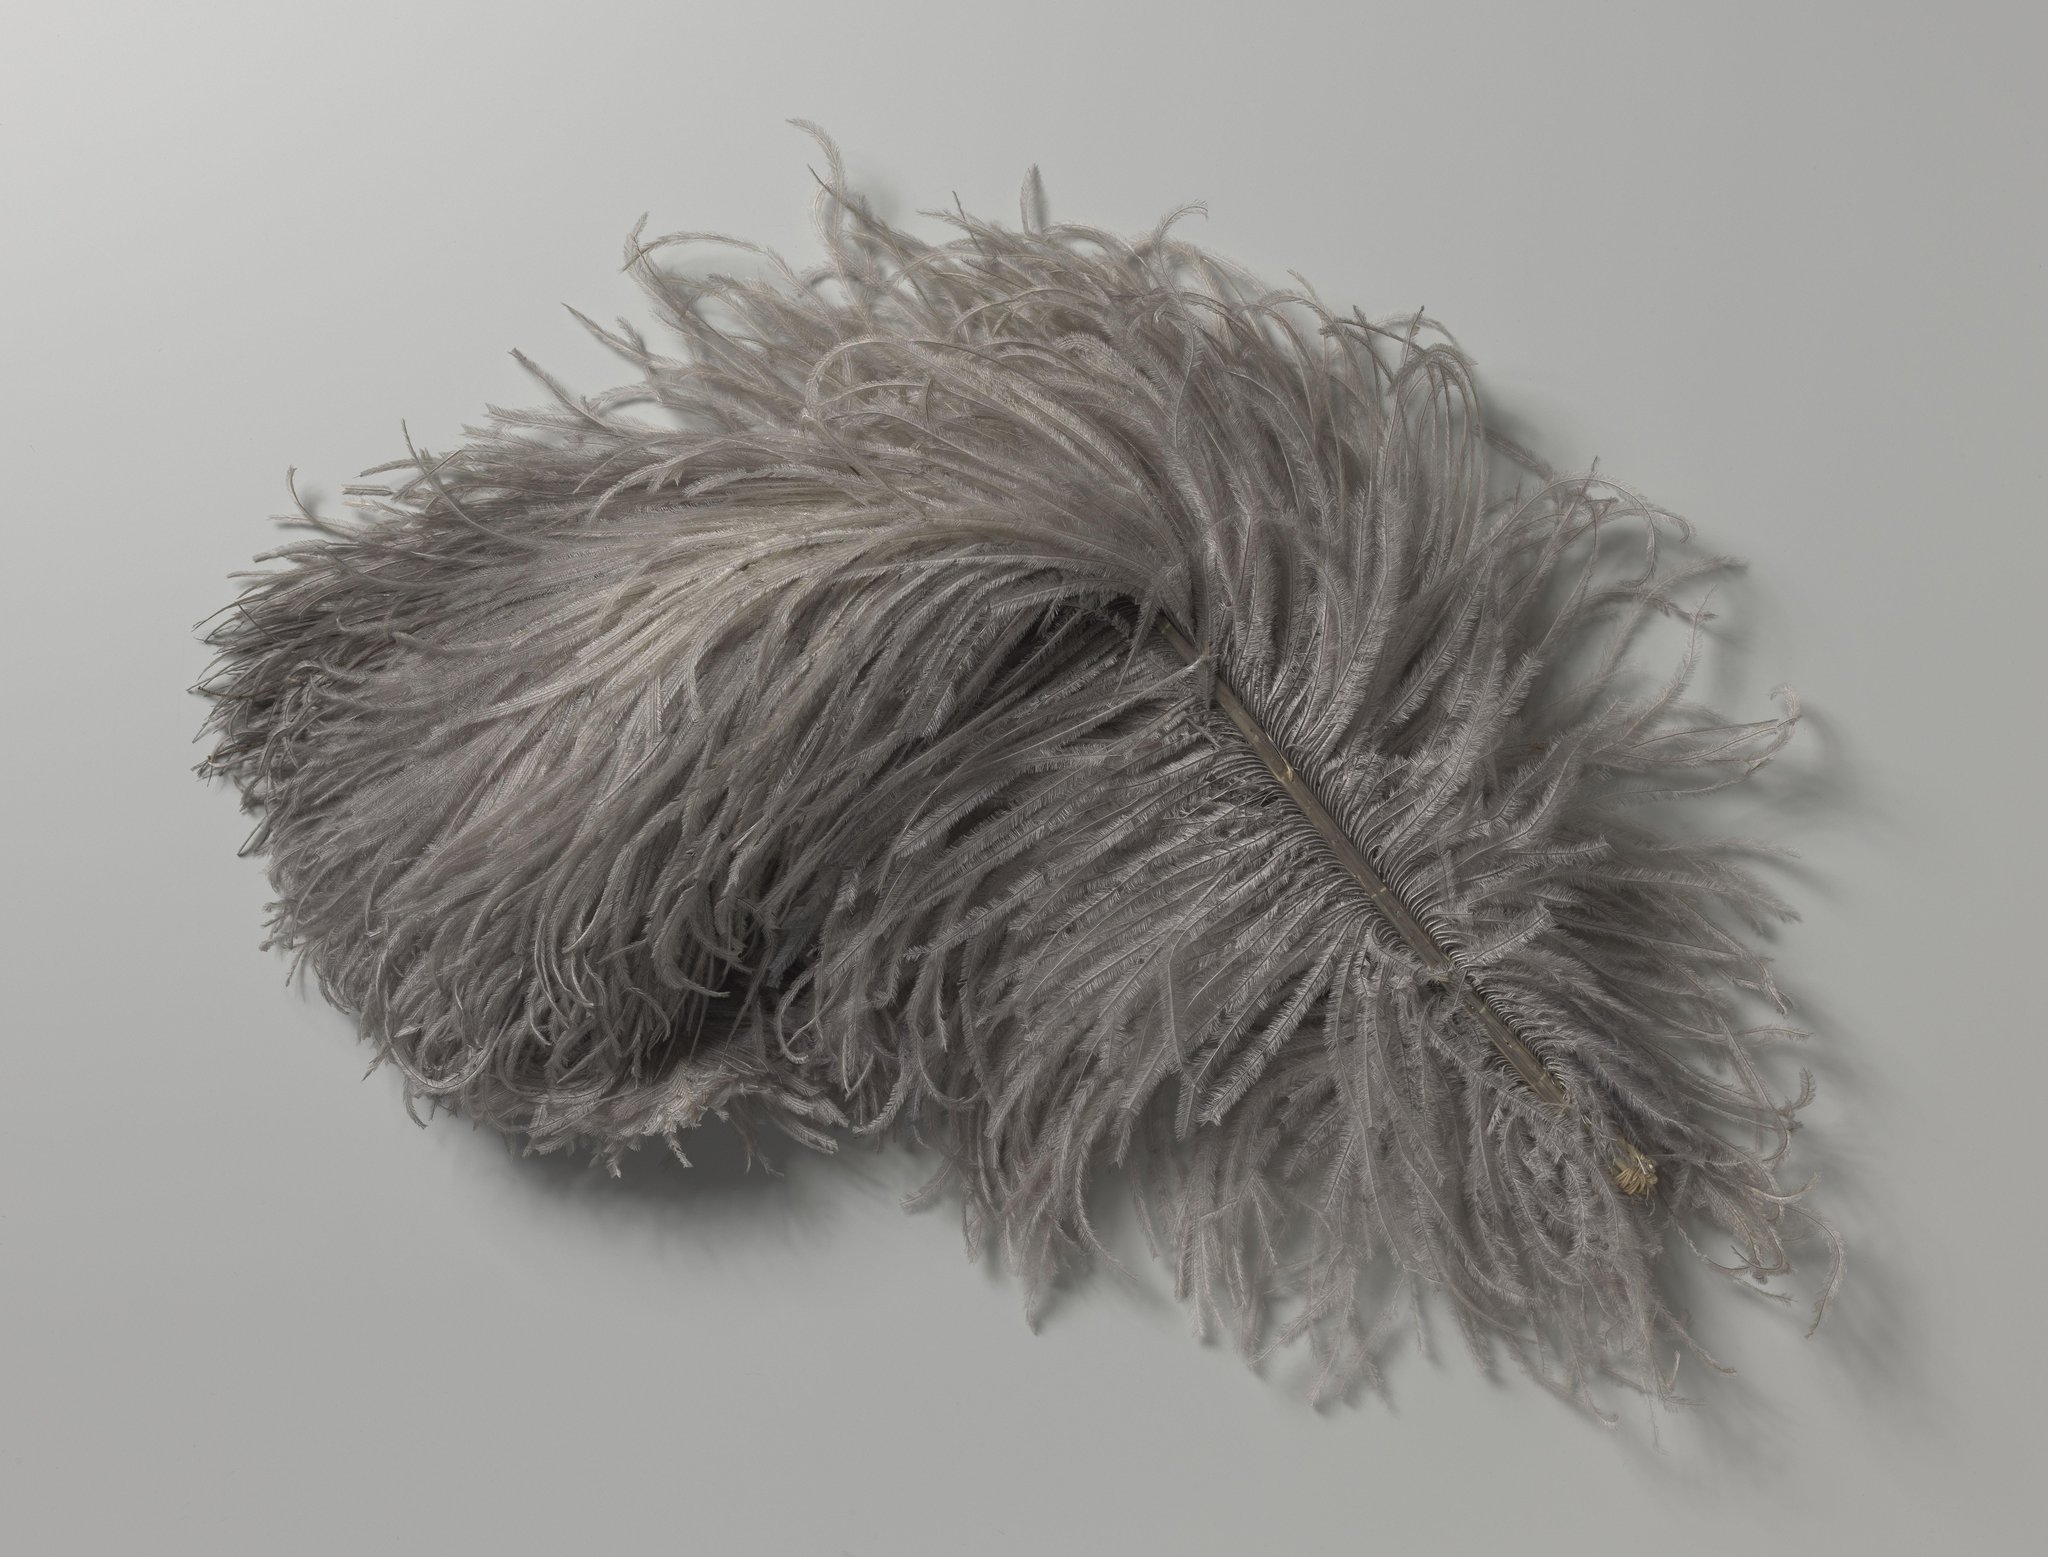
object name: hoedengarneersel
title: Struisveren, grijs van kleur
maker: Anonymous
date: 1895-1915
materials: ostrich feather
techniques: painting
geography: western europe